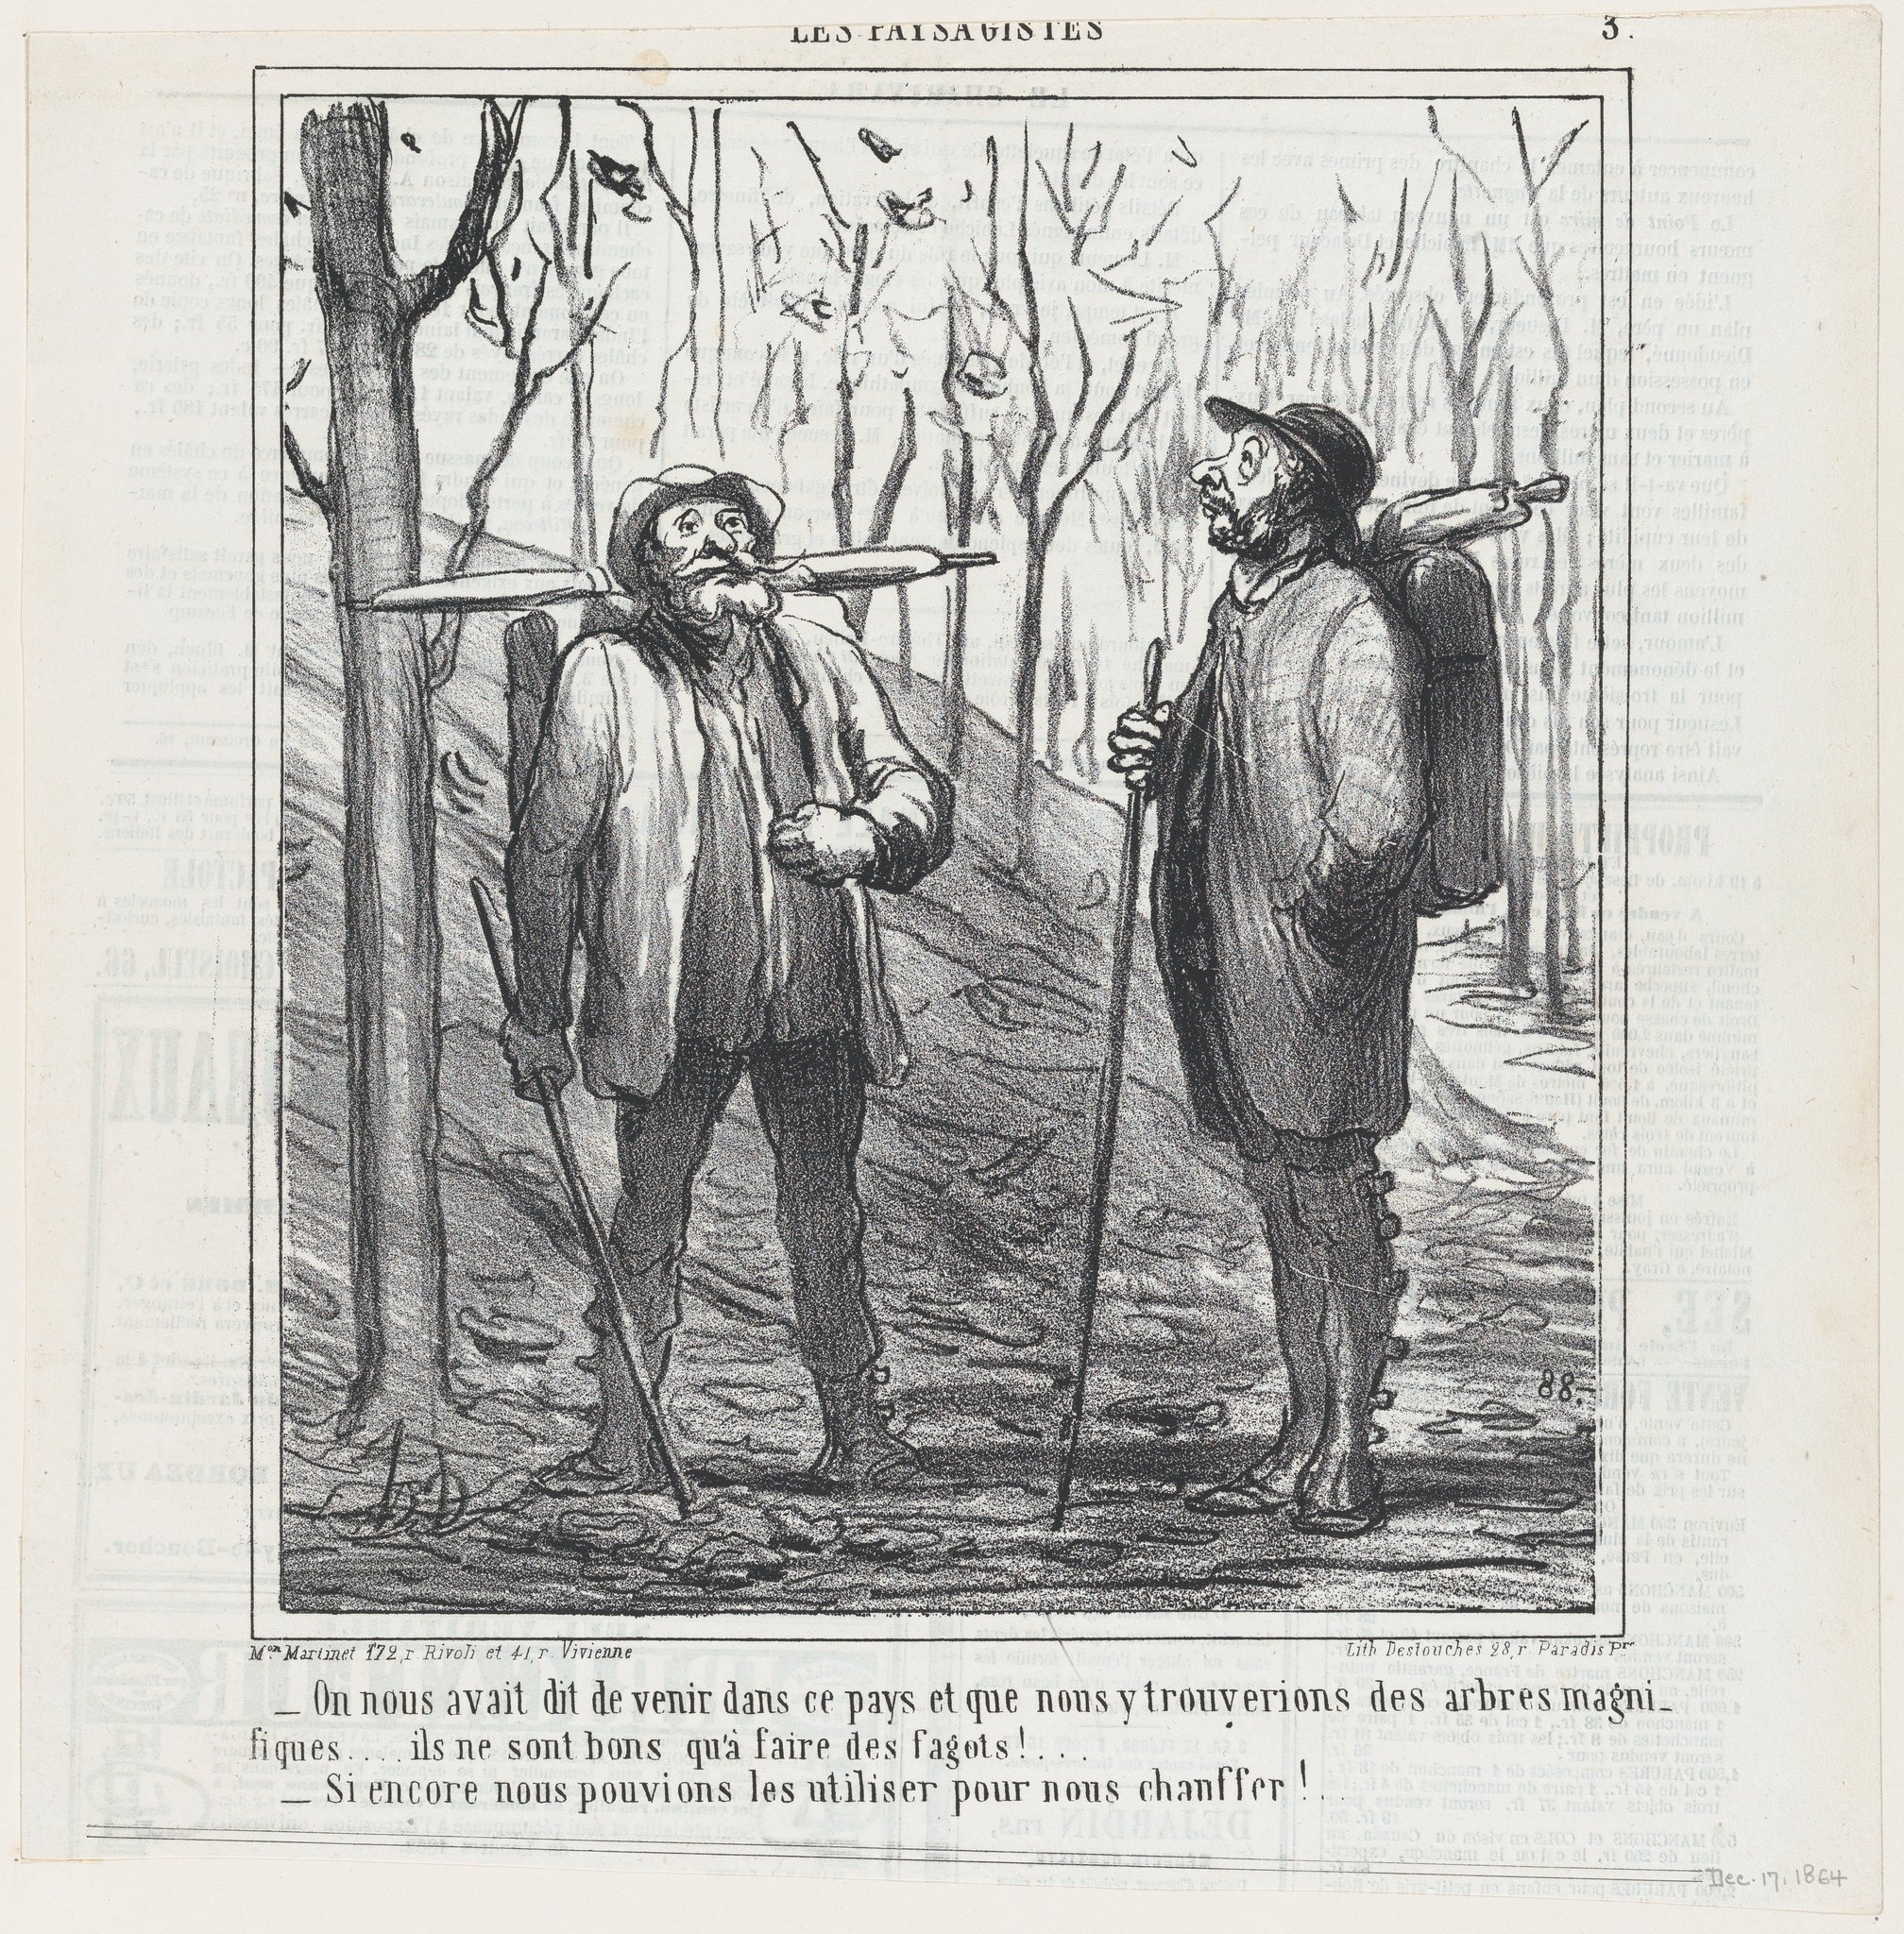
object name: print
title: They told us to come to this region and we would find some magnificent trees, from 'The landscape painters,' published in Le Charivari, December 17, 1864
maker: honoré daumier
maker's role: artist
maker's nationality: french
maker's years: 1808-1879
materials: paper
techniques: lithograph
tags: men,trees